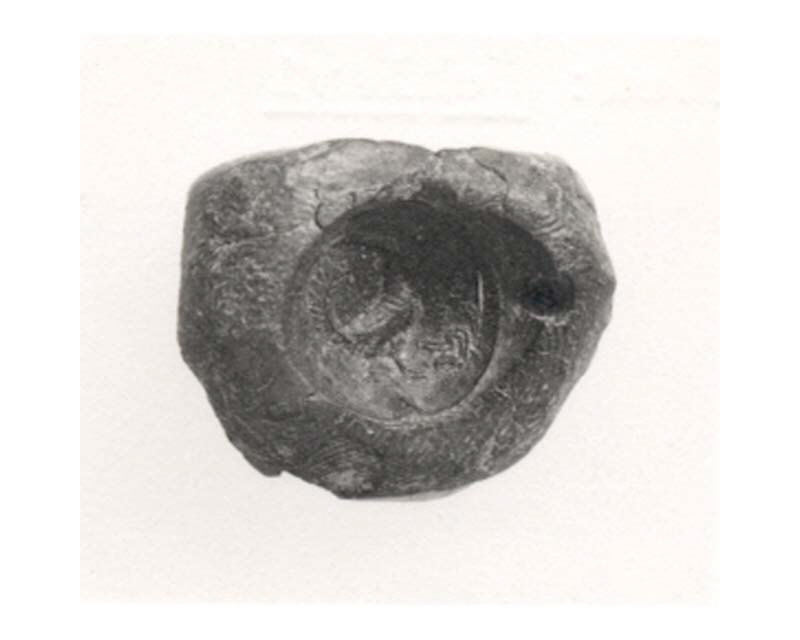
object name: sealing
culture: sasanian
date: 601-700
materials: clay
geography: iran